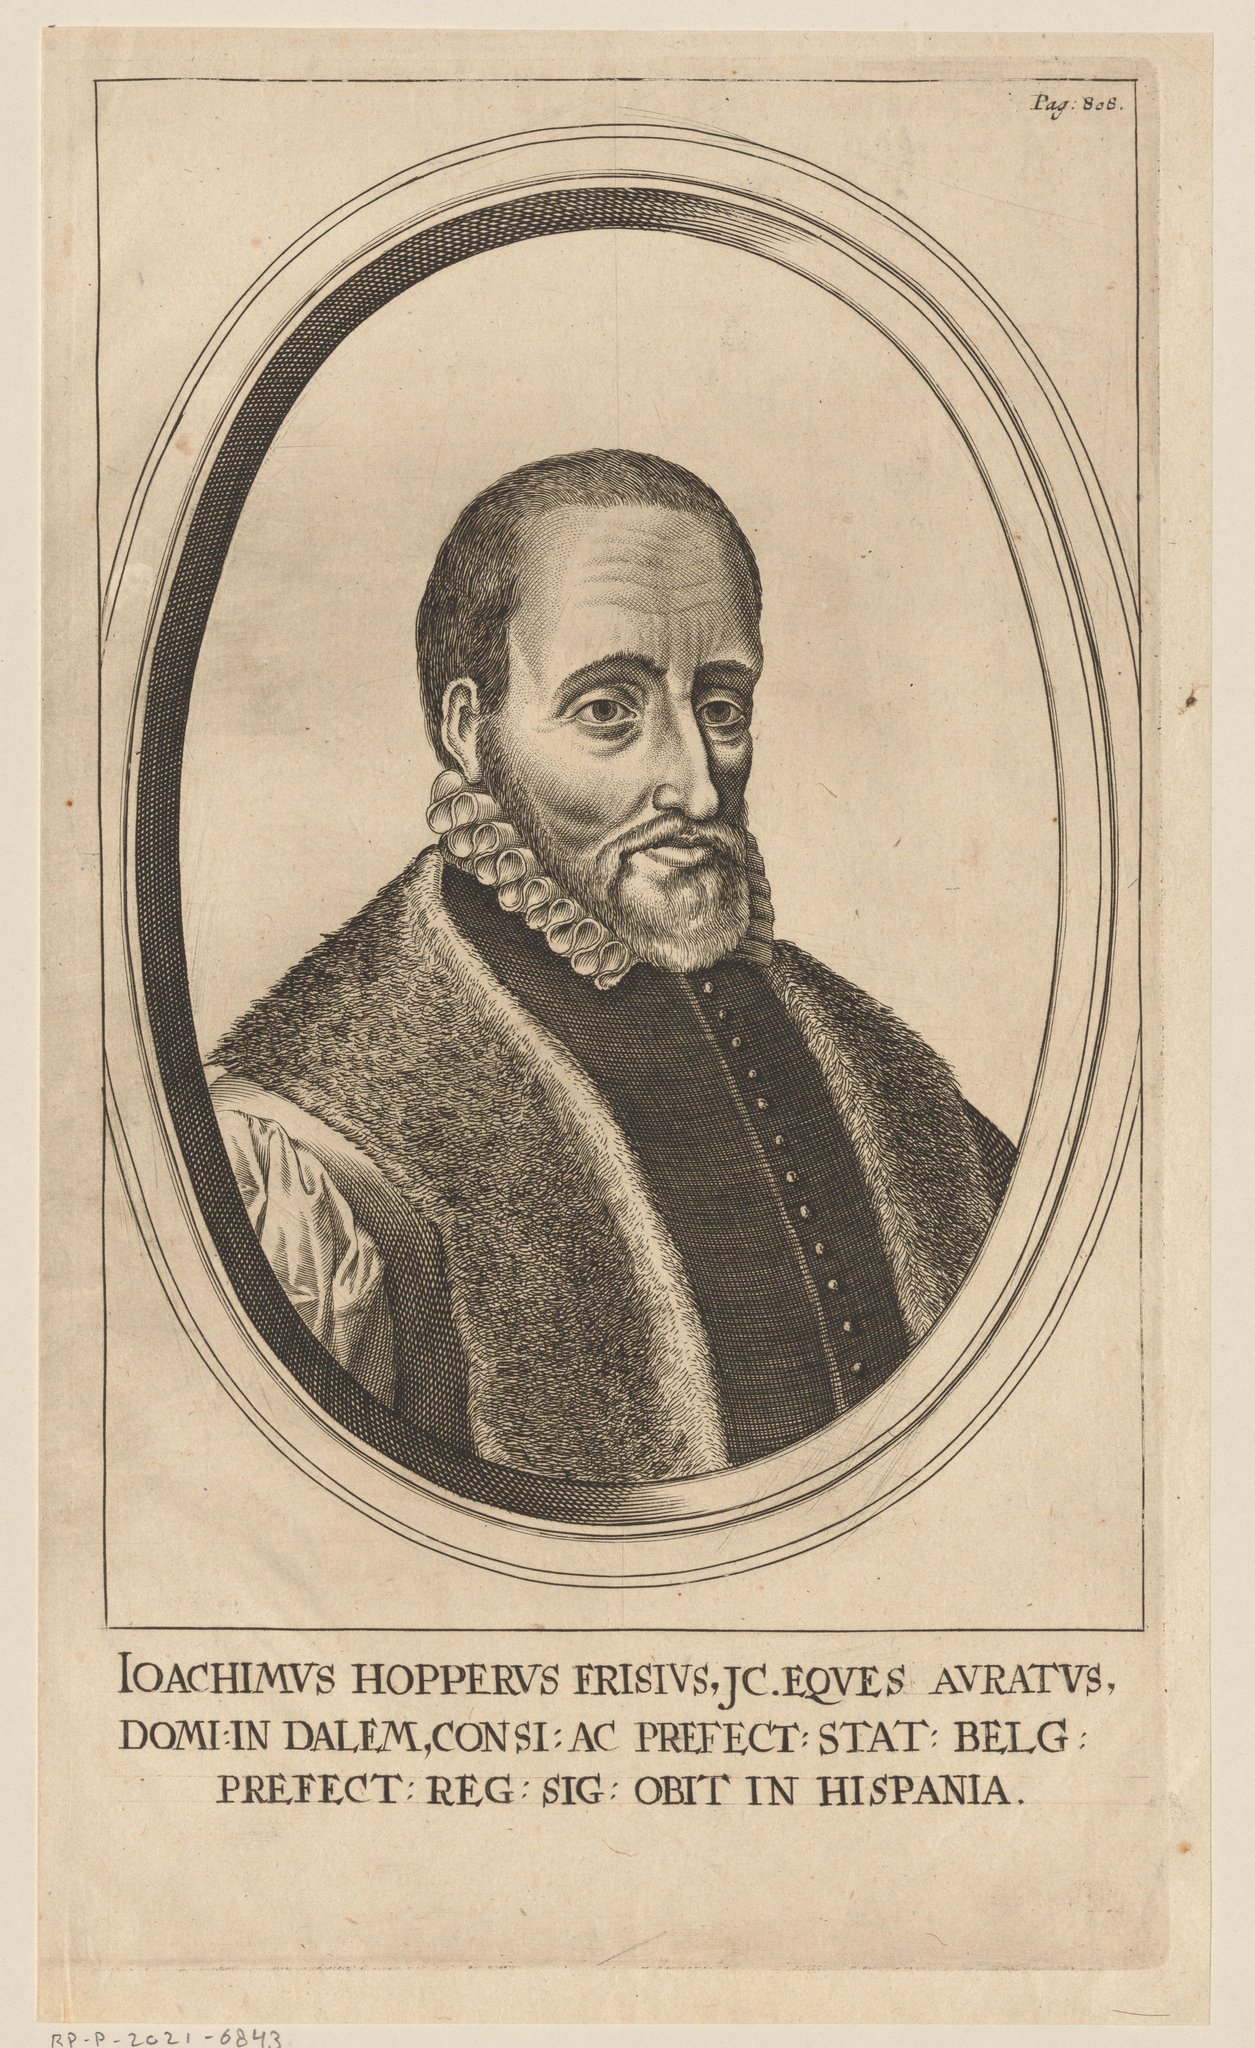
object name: print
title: Portret van Joachim Hopperus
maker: Anonymous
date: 1658-1660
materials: paper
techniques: engraving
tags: historical persons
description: Prent gebruikt in: Schotanus, Christianus. De geschiedenissen kerckelyck ende wereldtlyck van Friesland Oost ende West. Franeker: Johannes Wellens, 1658. En in: Schotanus, Christianus. De geschiedenissen kerckelyck ende wereldtlyck van Friesland Oost ende West. Amsterdam: Joost Pluymer, 1660.